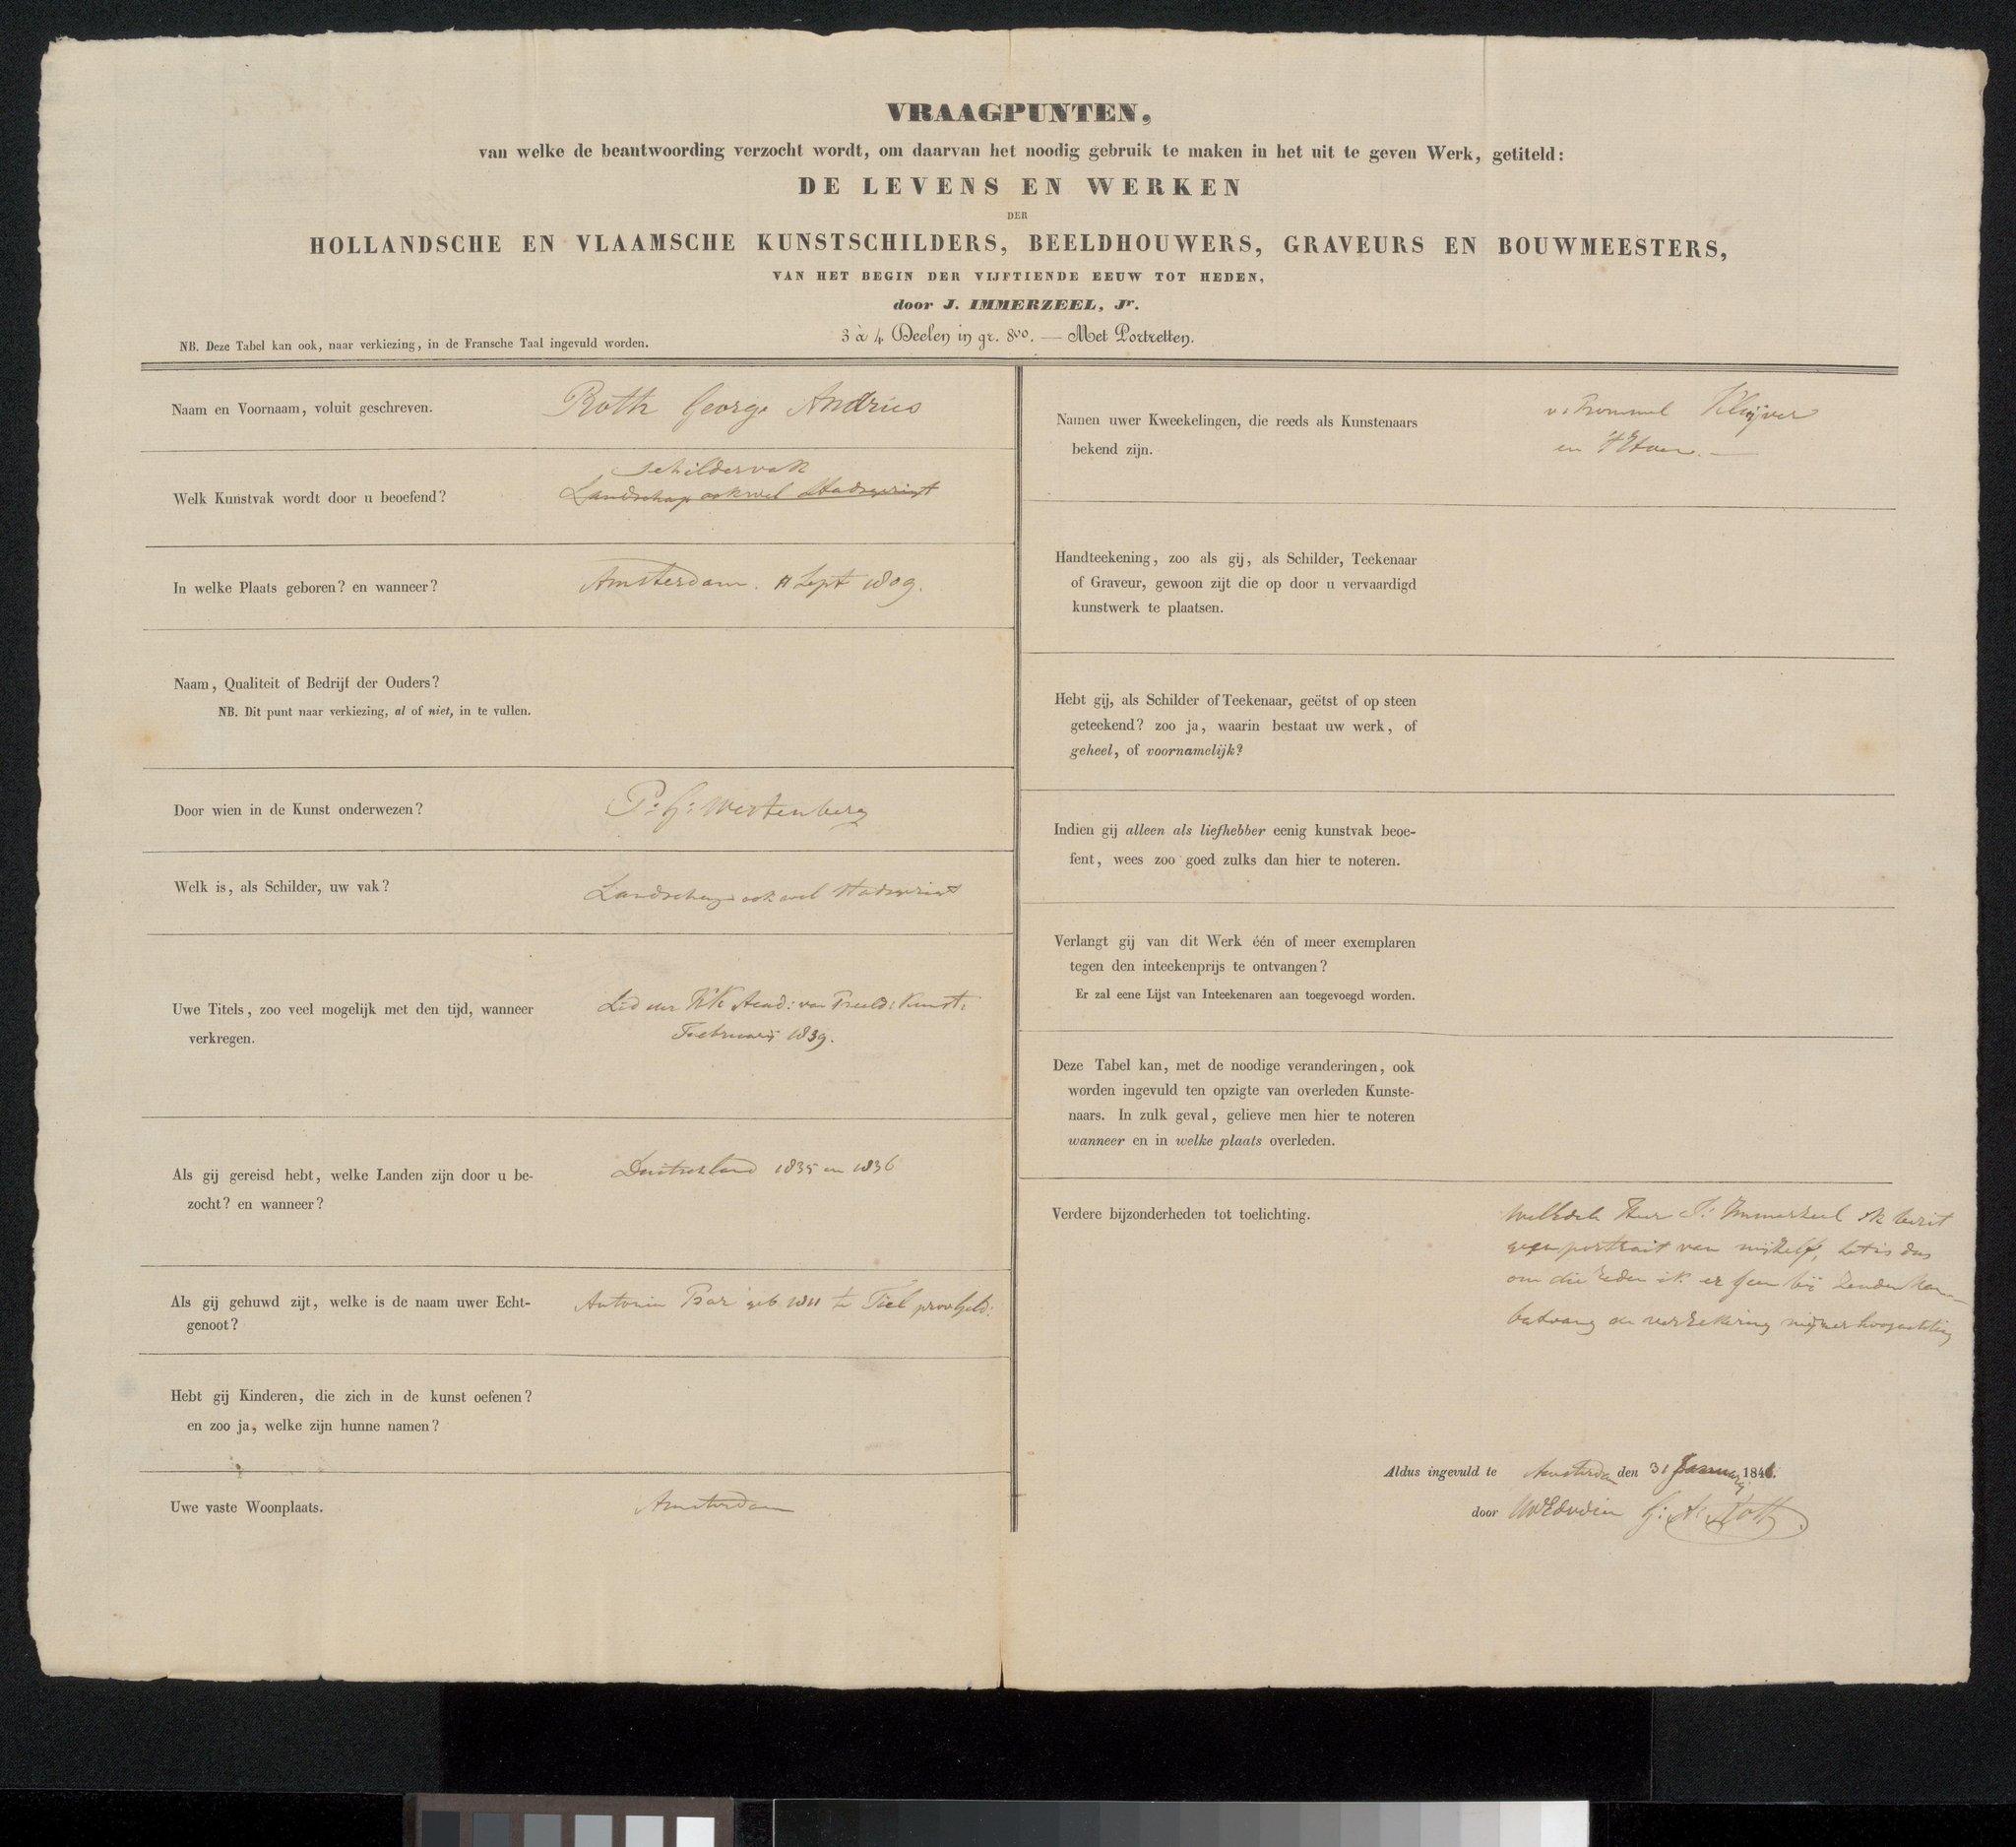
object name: manuscript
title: Enquêteformulier ingevuld door George Andries Roth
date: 1841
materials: ink, paper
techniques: pen, printing, writing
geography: amsterdam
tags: painter, print maker, draughtsman, george andries roth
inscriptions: watermark, inscription: ‘Vraagpunten,/ van welke de beantwoording verzocht wordt, om daarvan het noodig gebruik te maken in het uit te geven Werk, getiteld: De levens en werken/ der Hollandsche en Vlaamsche kunstschilders, beeldhouwers,/ graveurs en bouwmeesters, van het begin der vijftiende eeuw tot heden/ door J. Immerzeel, Jr.’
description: Opgenomen in: Immerzeel, J. Jr., De levens en werken der Hollandsche en Vlaamsche kunstschilders, beeldhouwers, graveurs en bouwmeesters, van het begin der vijftiende eeuw tot heden, Amsterdam: J.C. van Kesteren, 1842-1843.